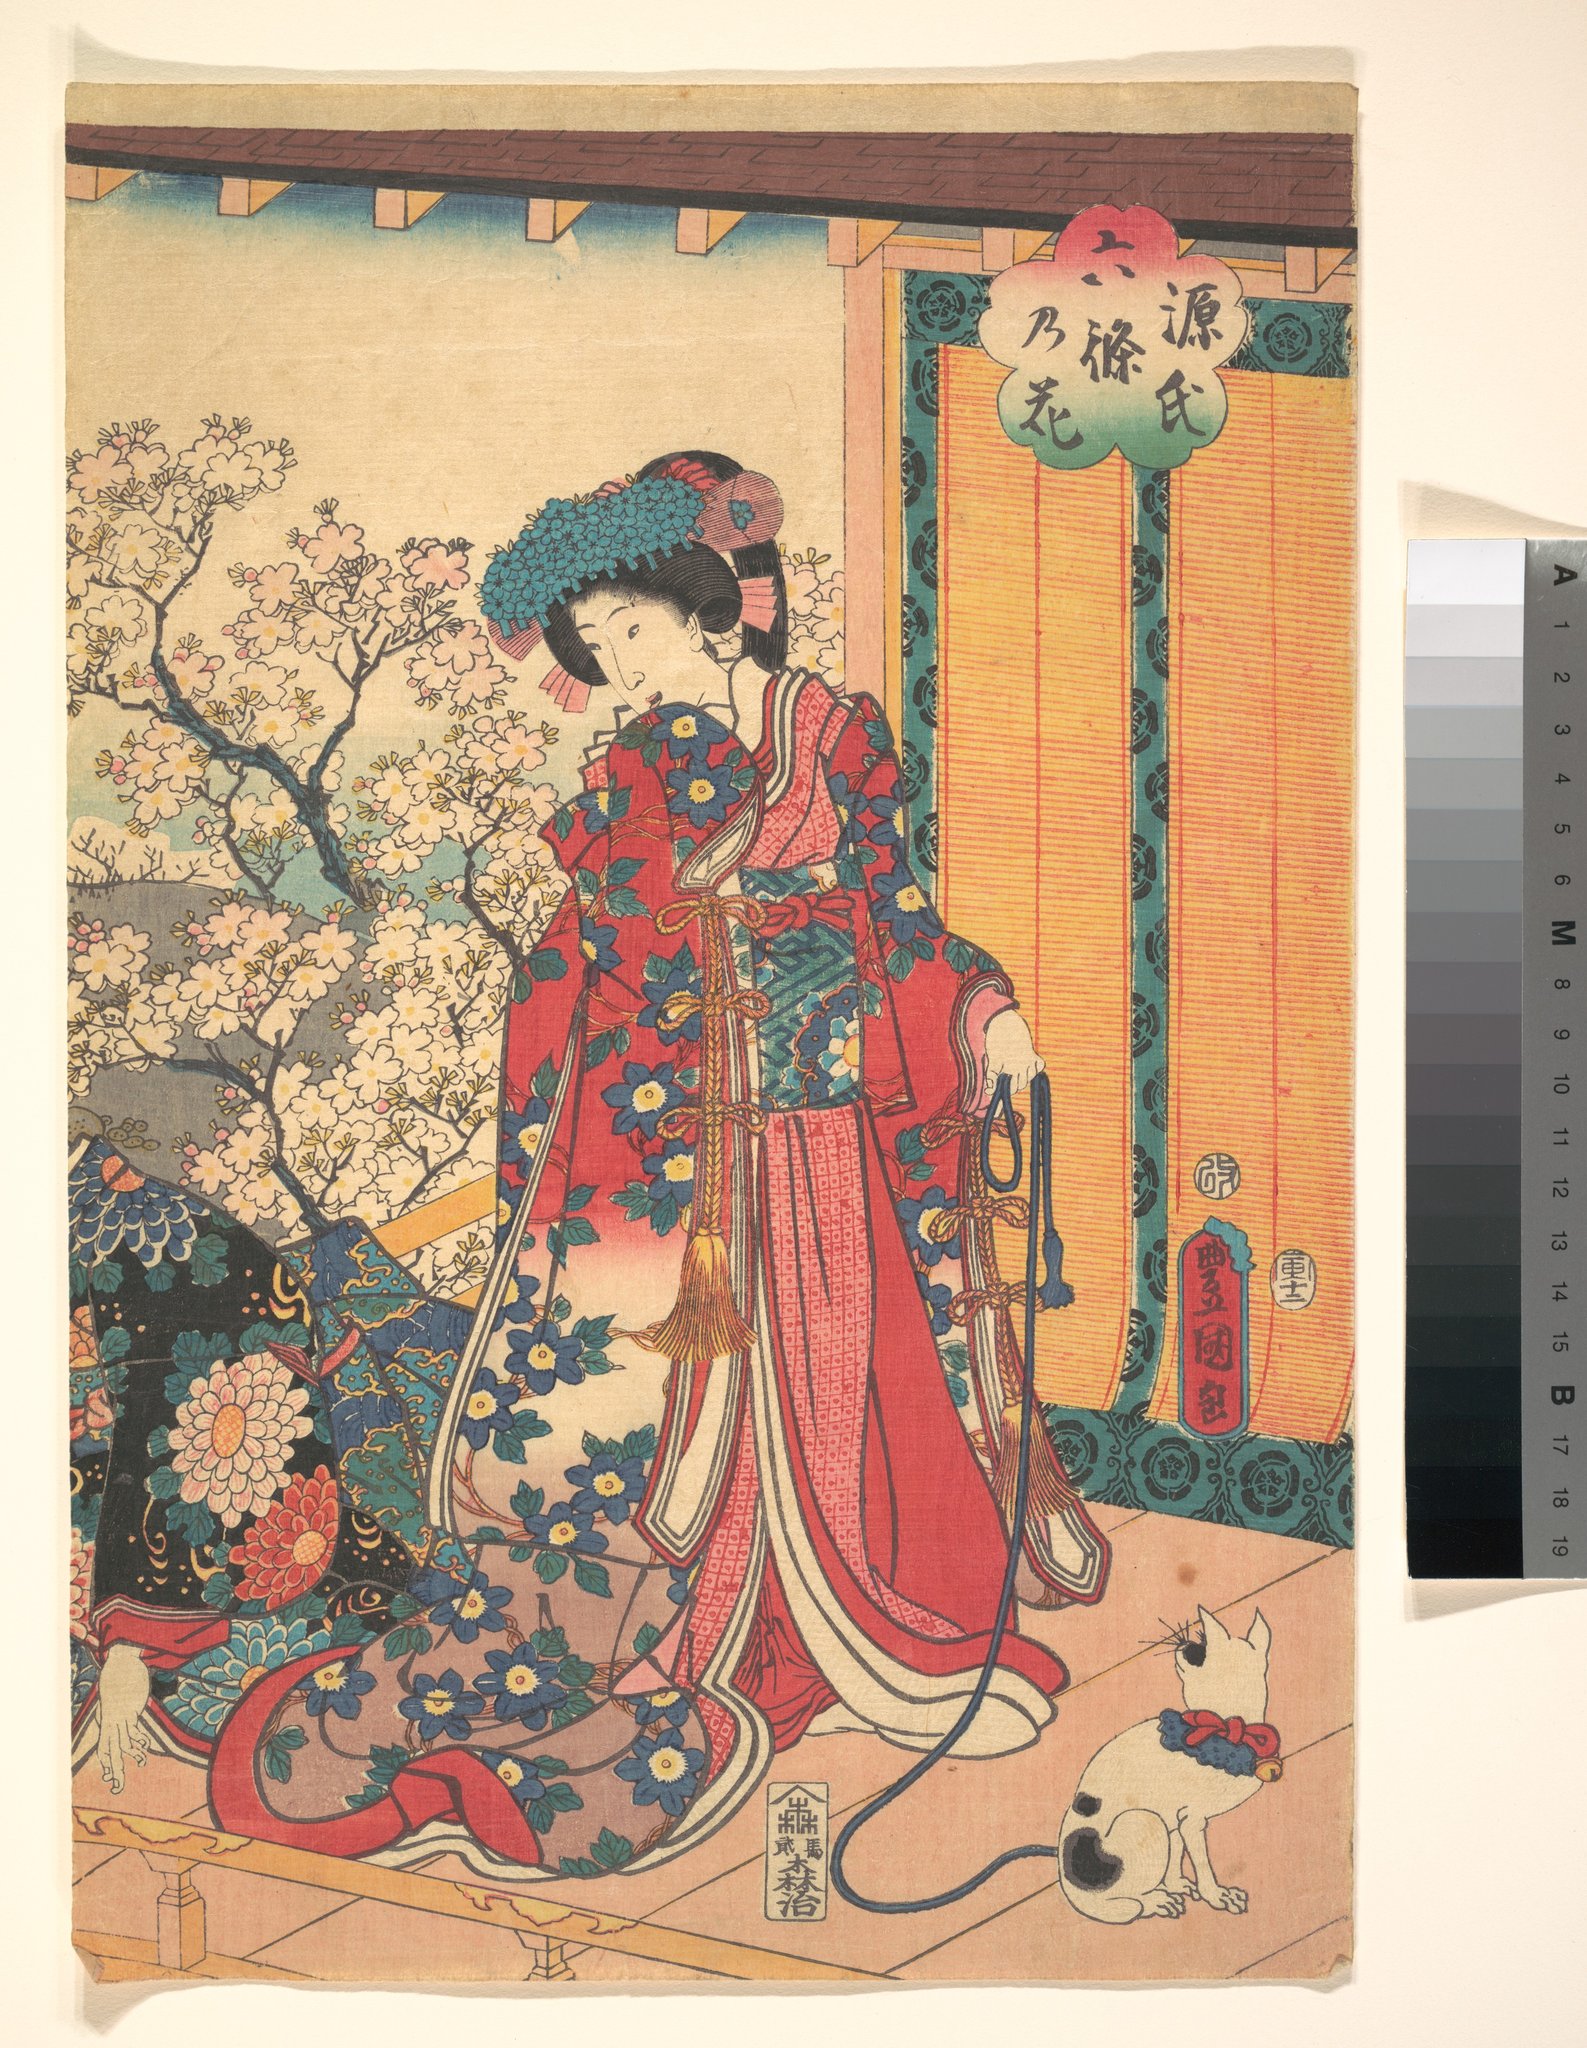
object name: print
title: Genji roku no hana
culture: japanese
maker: utagawa kunisada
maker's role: artist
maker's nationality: japanese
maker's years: 1786-1864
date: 1854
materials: ink, paper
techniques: woodblock print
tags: animals,women,flowers,trees